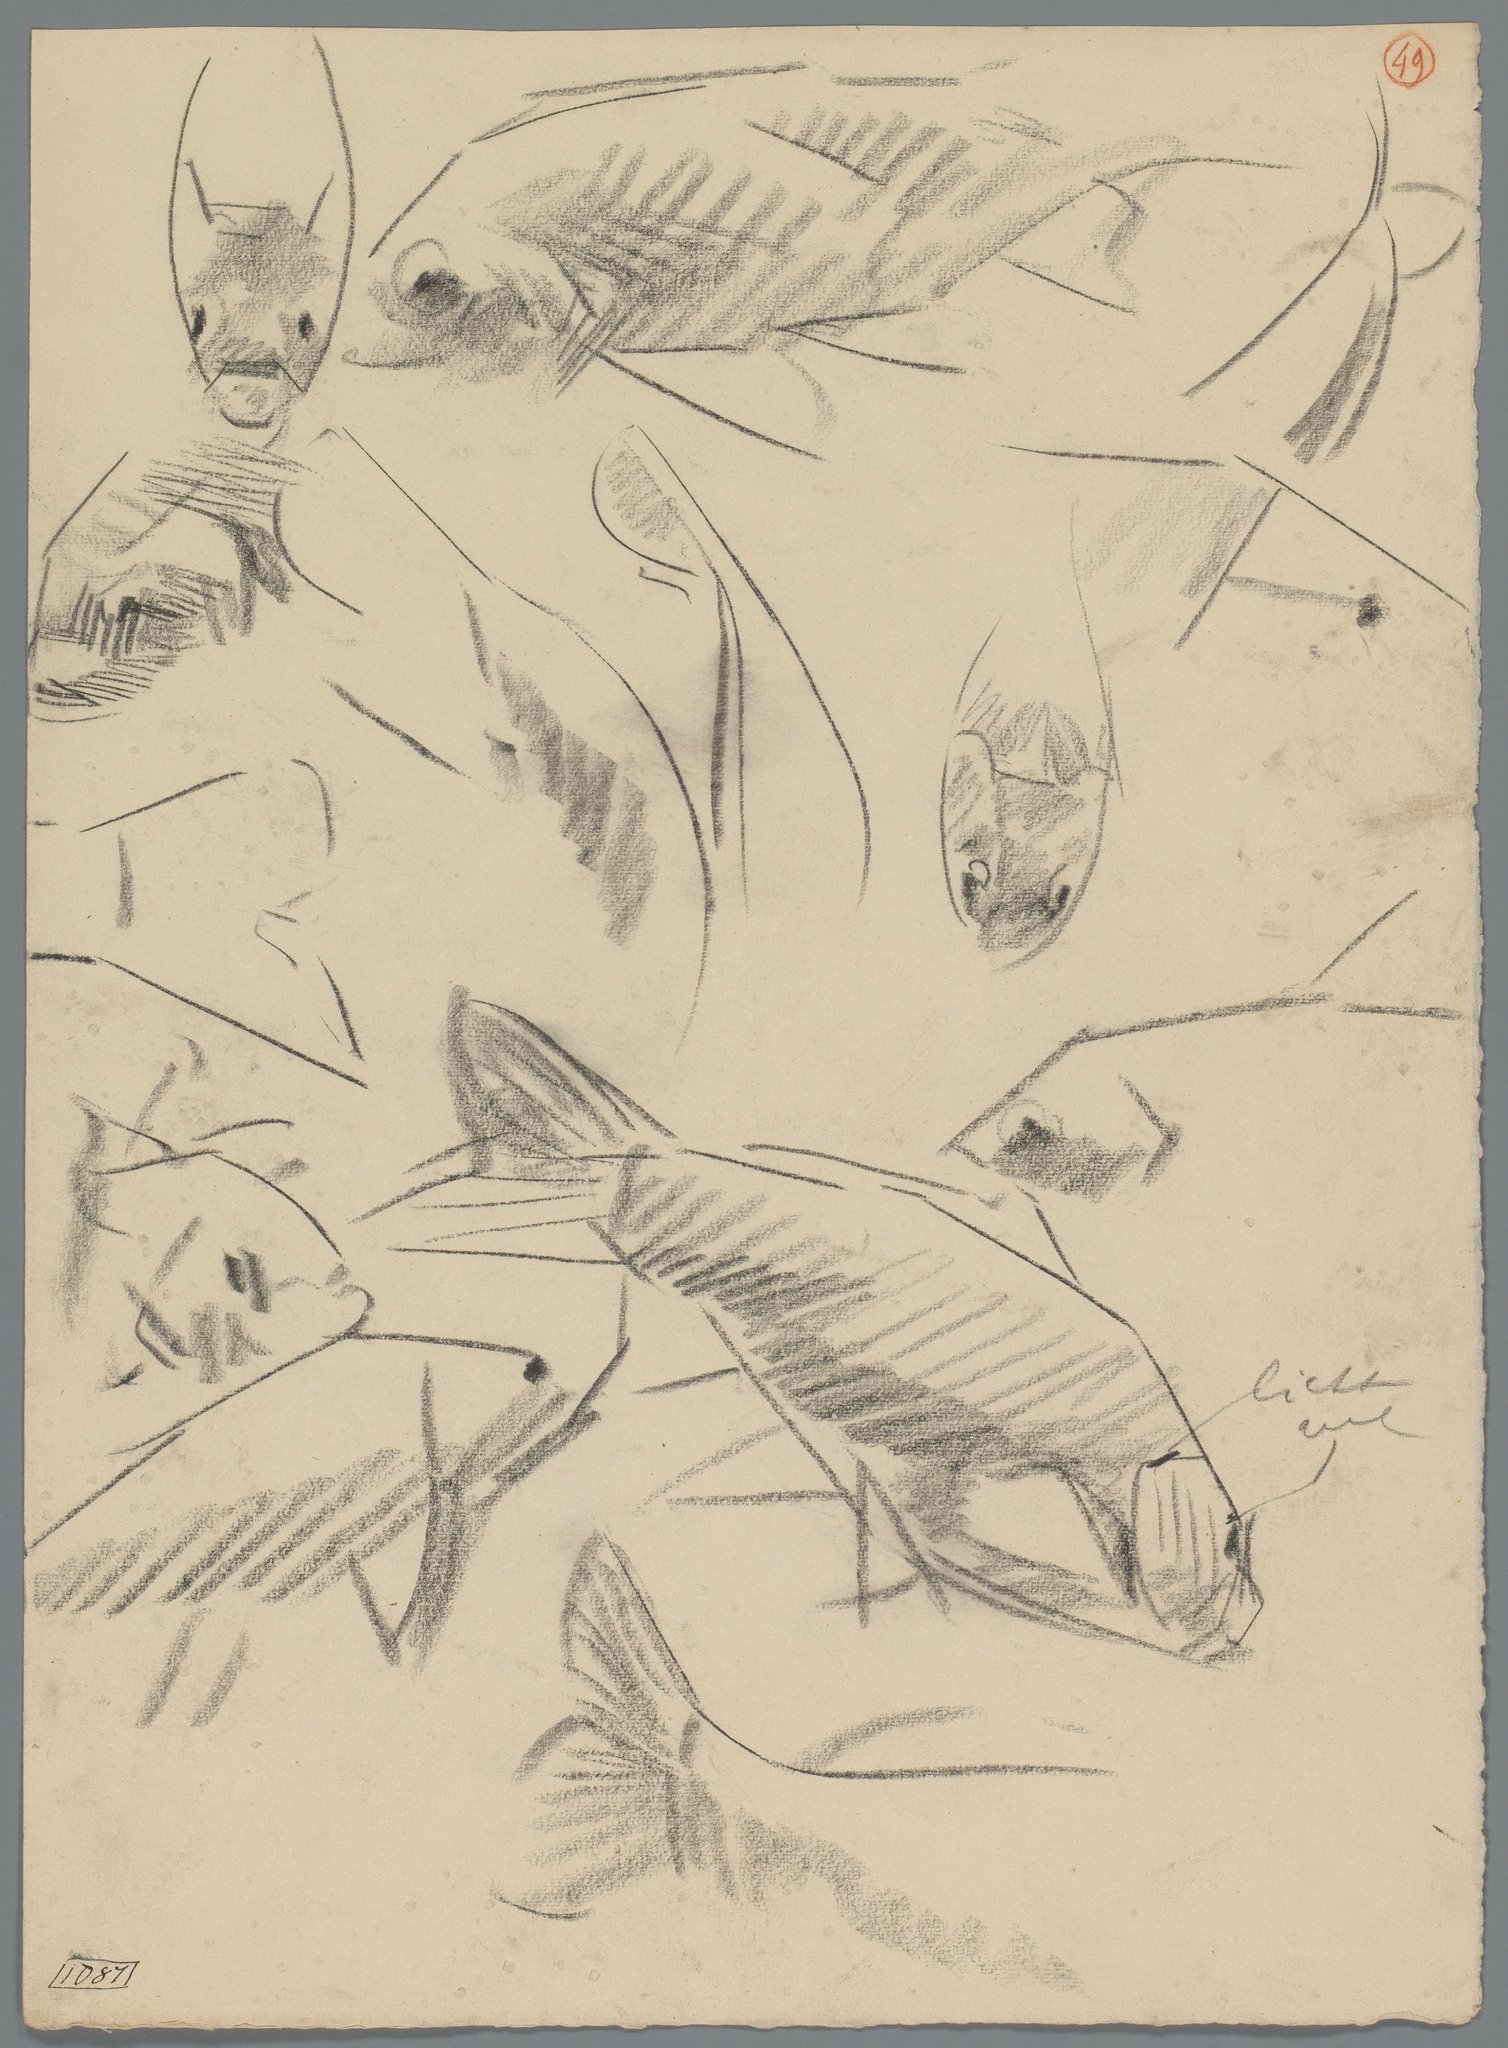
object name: drawing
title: Studies van karpers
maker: gerrit willem dijsselhof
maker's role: designer, draughtsman, print maker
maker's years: 1866-1924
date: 1876-1924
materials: chalk, paper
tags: bony fishes: carp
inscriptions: number: ‘1087’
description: Met aantekeningen. Rechtsboven genummerd: 49.